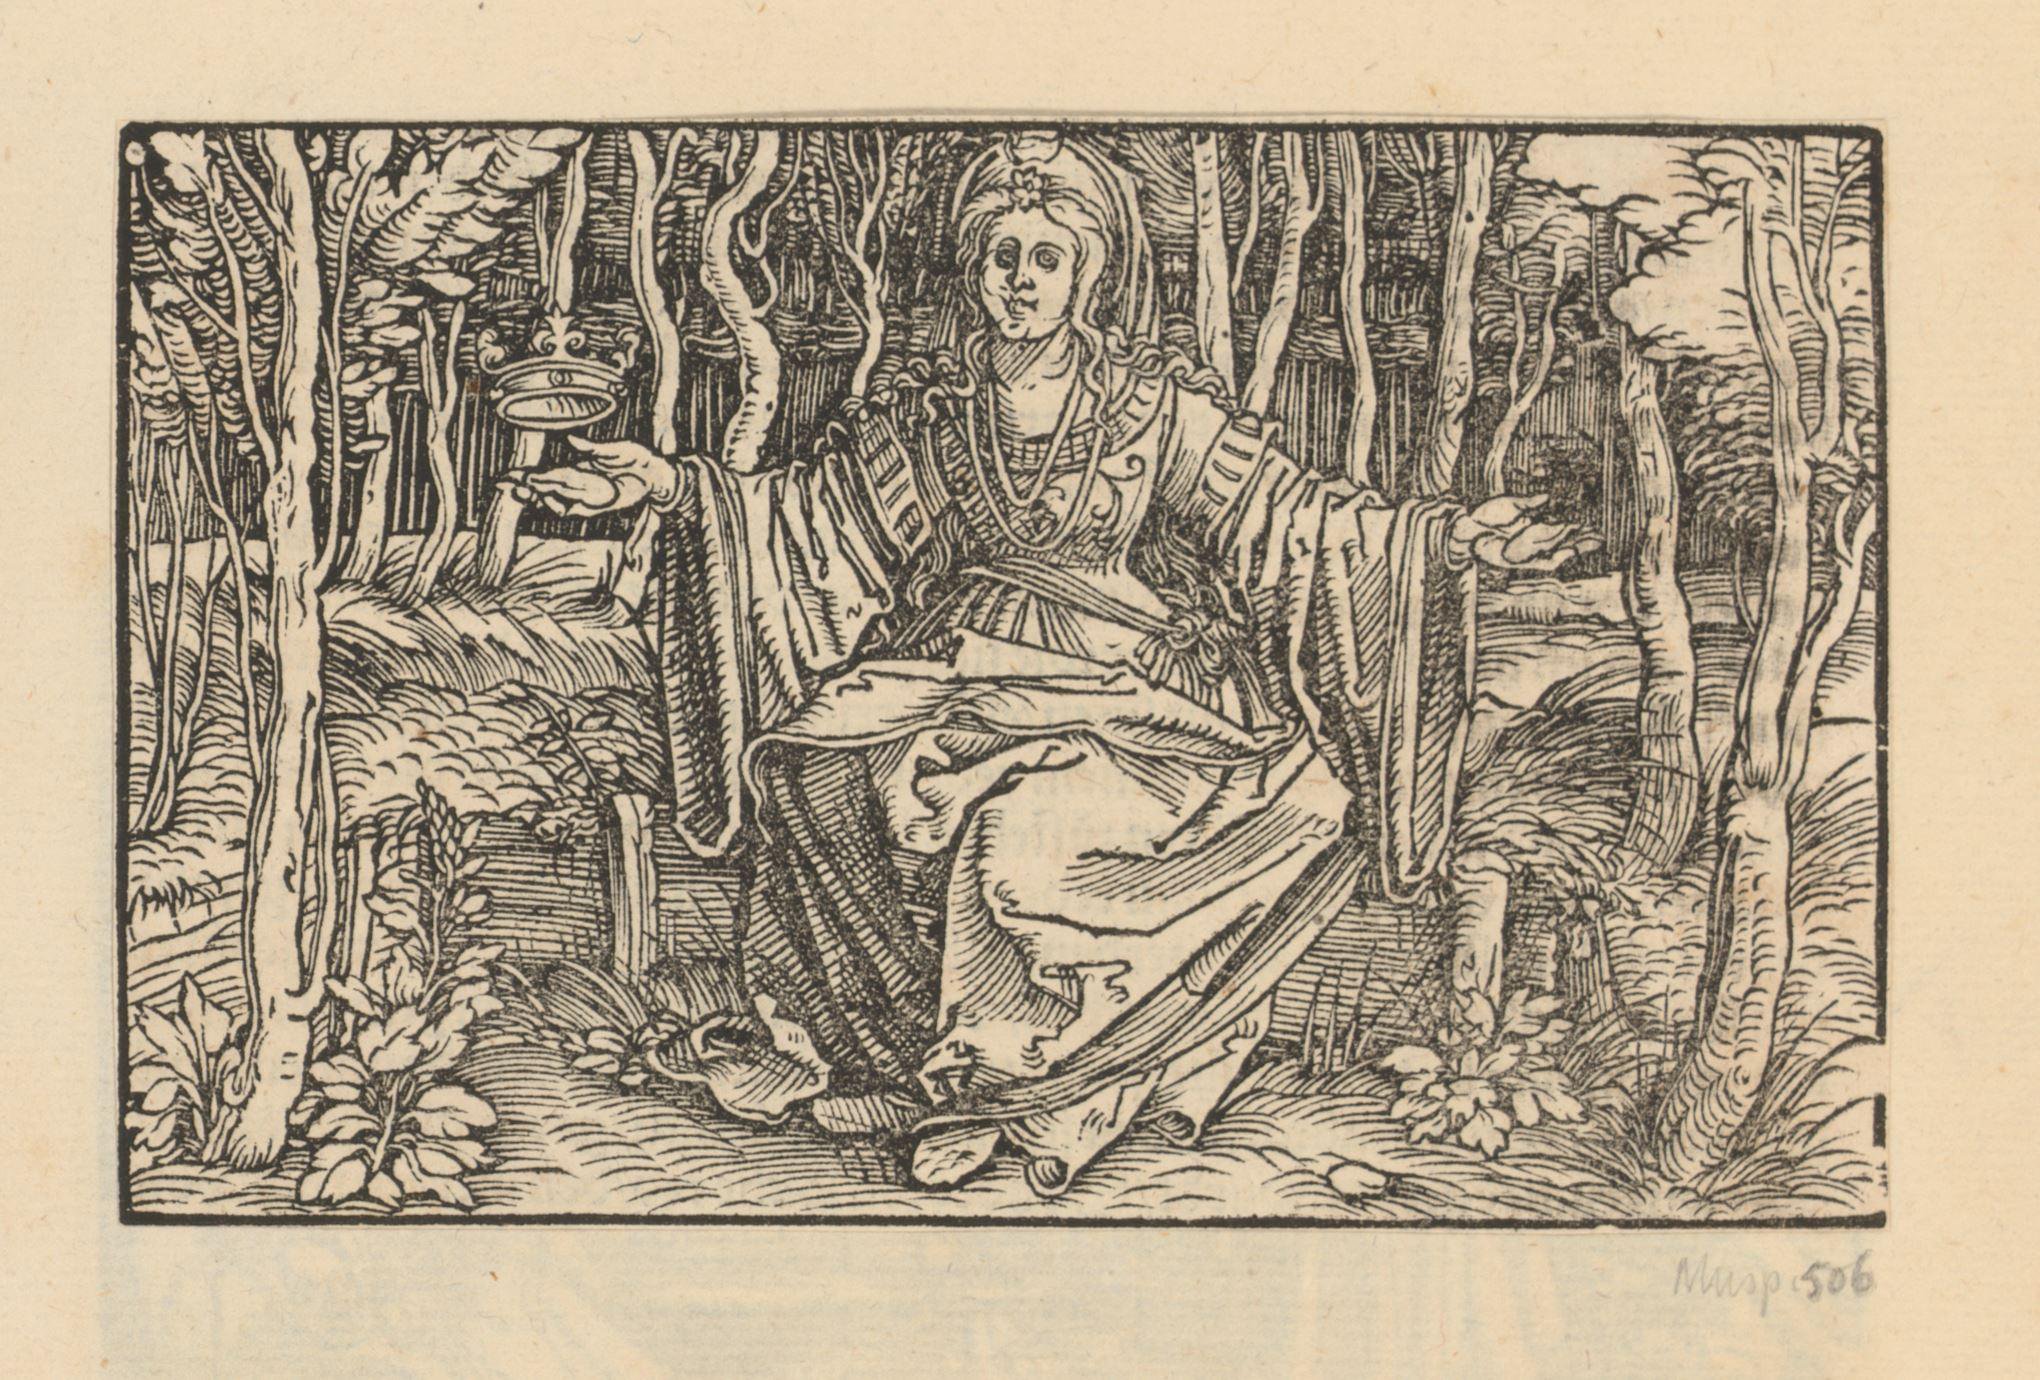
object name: print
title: Vrouw weegt het goede tegen het kwade af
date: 1514-1531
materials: paper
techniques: letterpress printing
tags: good and bad behaviour, moral qualities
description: Deze prent is gebruikt in: Cicero, Marcus Tulius. Officia M.T.C. Ein Buch so Marcus Tullius Cicero der Römer zu seynem (...). [Vertaald uit het Latijn door] Johann von Schwarzenberg. Augsburg: Heinrich Steiner, 1531.